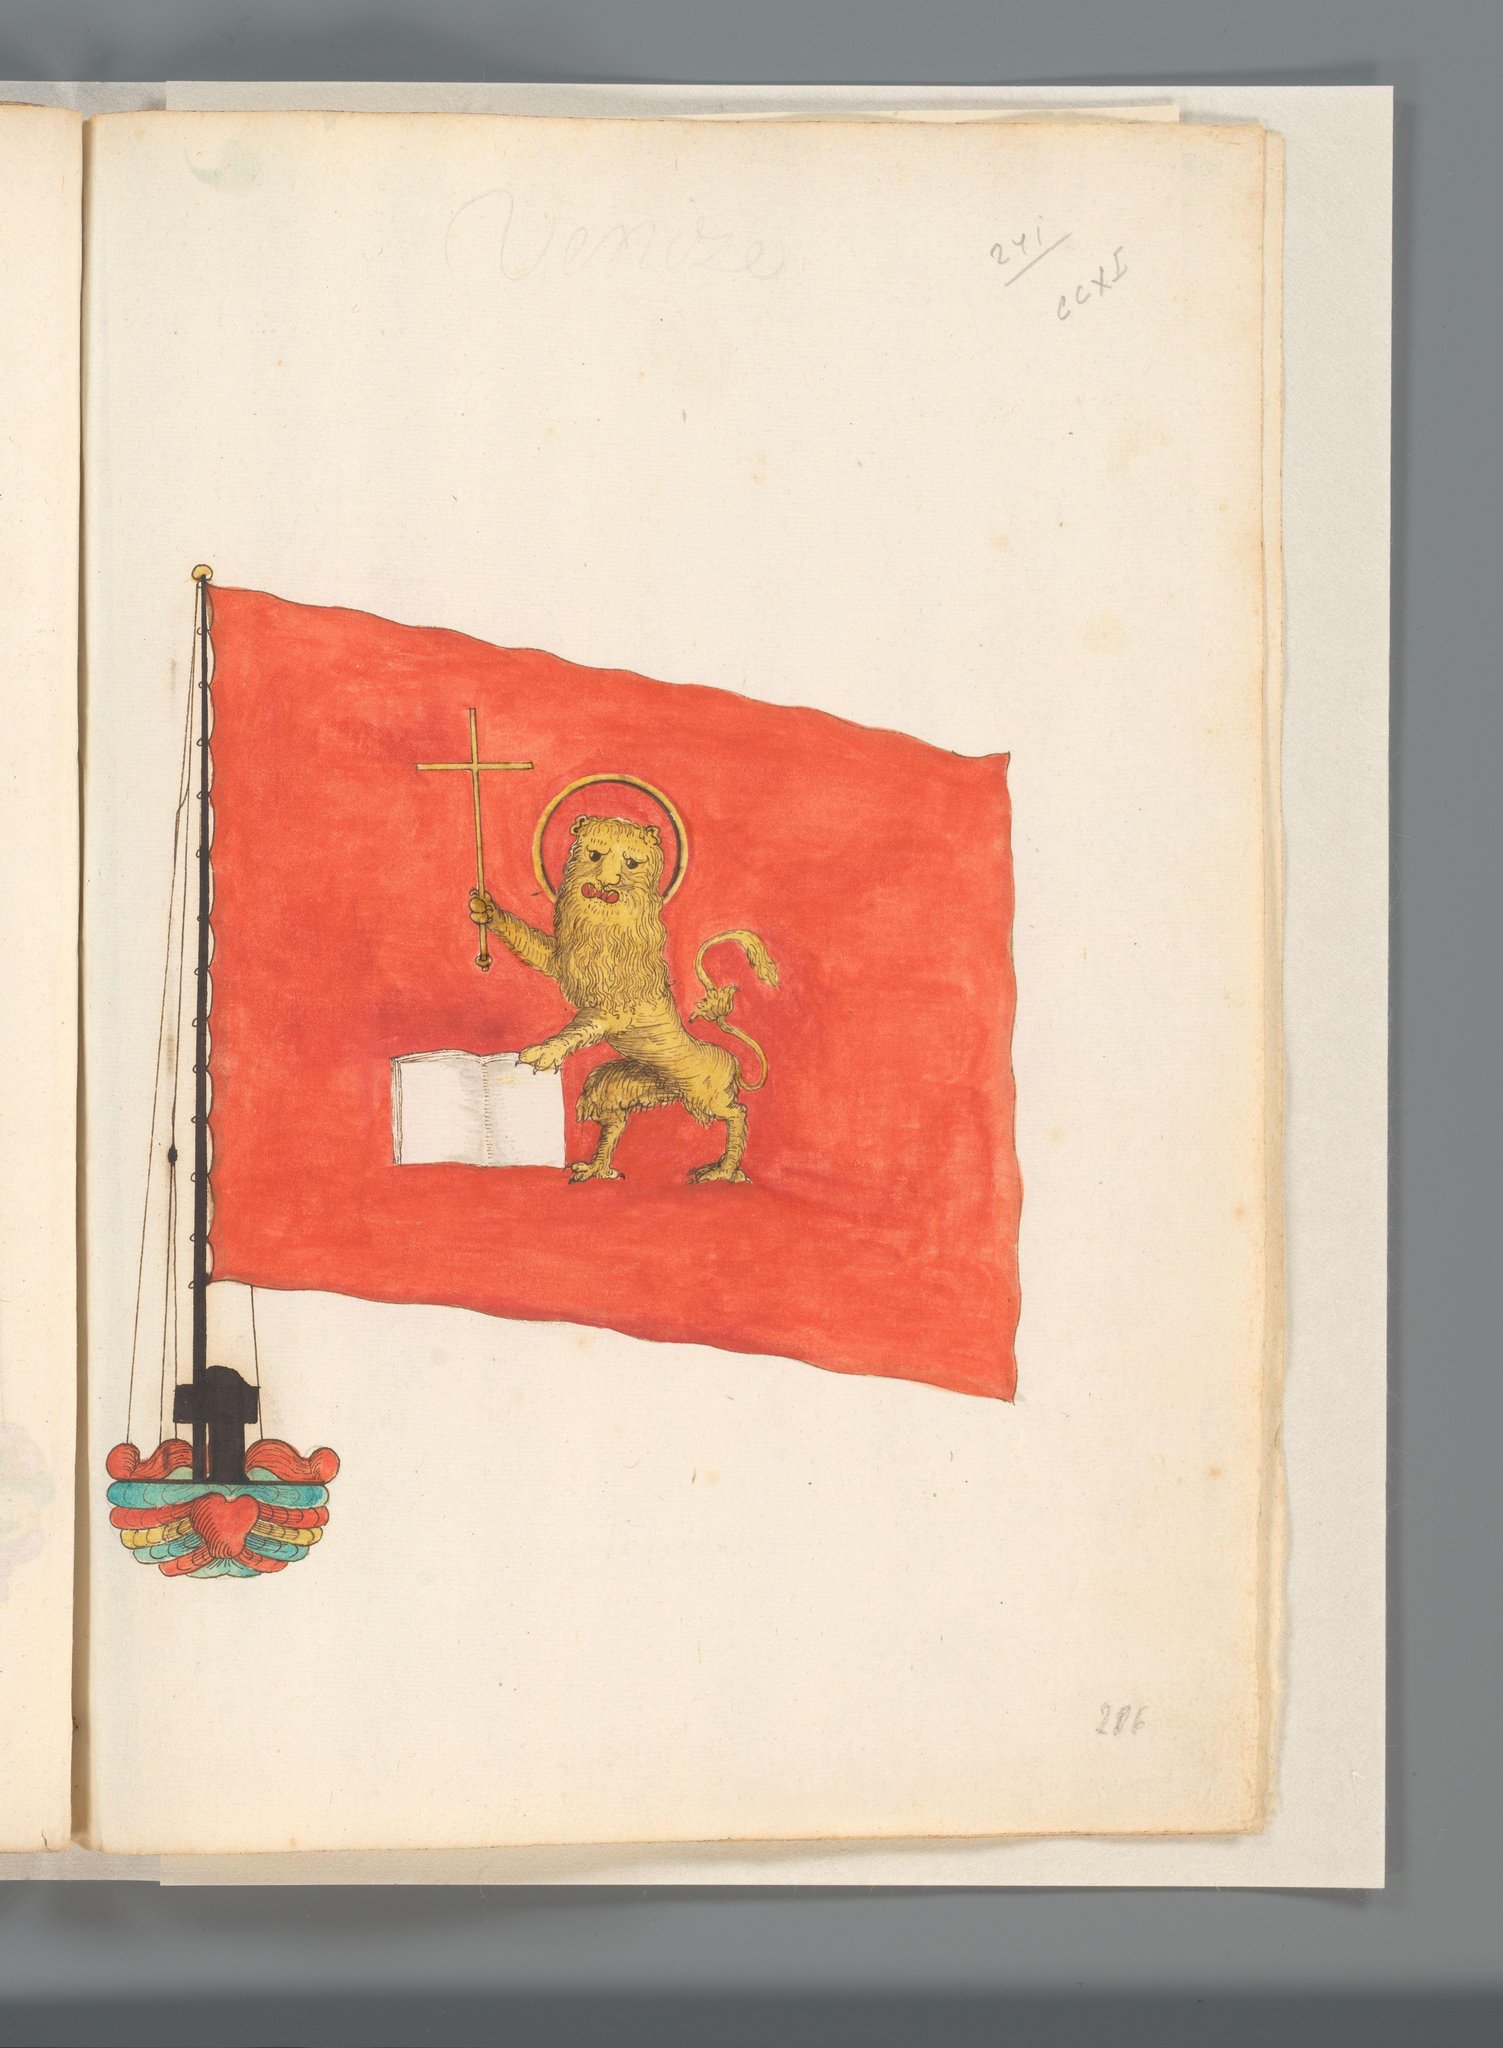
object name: drawing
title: Vlag van Venetië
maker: Anonymous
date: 1667-1670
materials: ink, paper, watercolor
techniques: brush, pen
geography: france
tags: flag, colours (as symbol of the state, etc.), venice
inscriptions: number: ‘241 / CCXI / 211’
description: Vlag van Venetië. Rode vlag waarop centraal een staande leeuw met aureool (symbool van de evangelist Marcus) met een open boek onder de ene poot en een kruis in de andere poot. Vlag op vlaggensteng en mastvoet. Afgebeeld op folio 106r. Onderdeel van een vlaggenboek met vlaggen uit Europa, Noord-Afrika, Nabije en Verre Oosten.